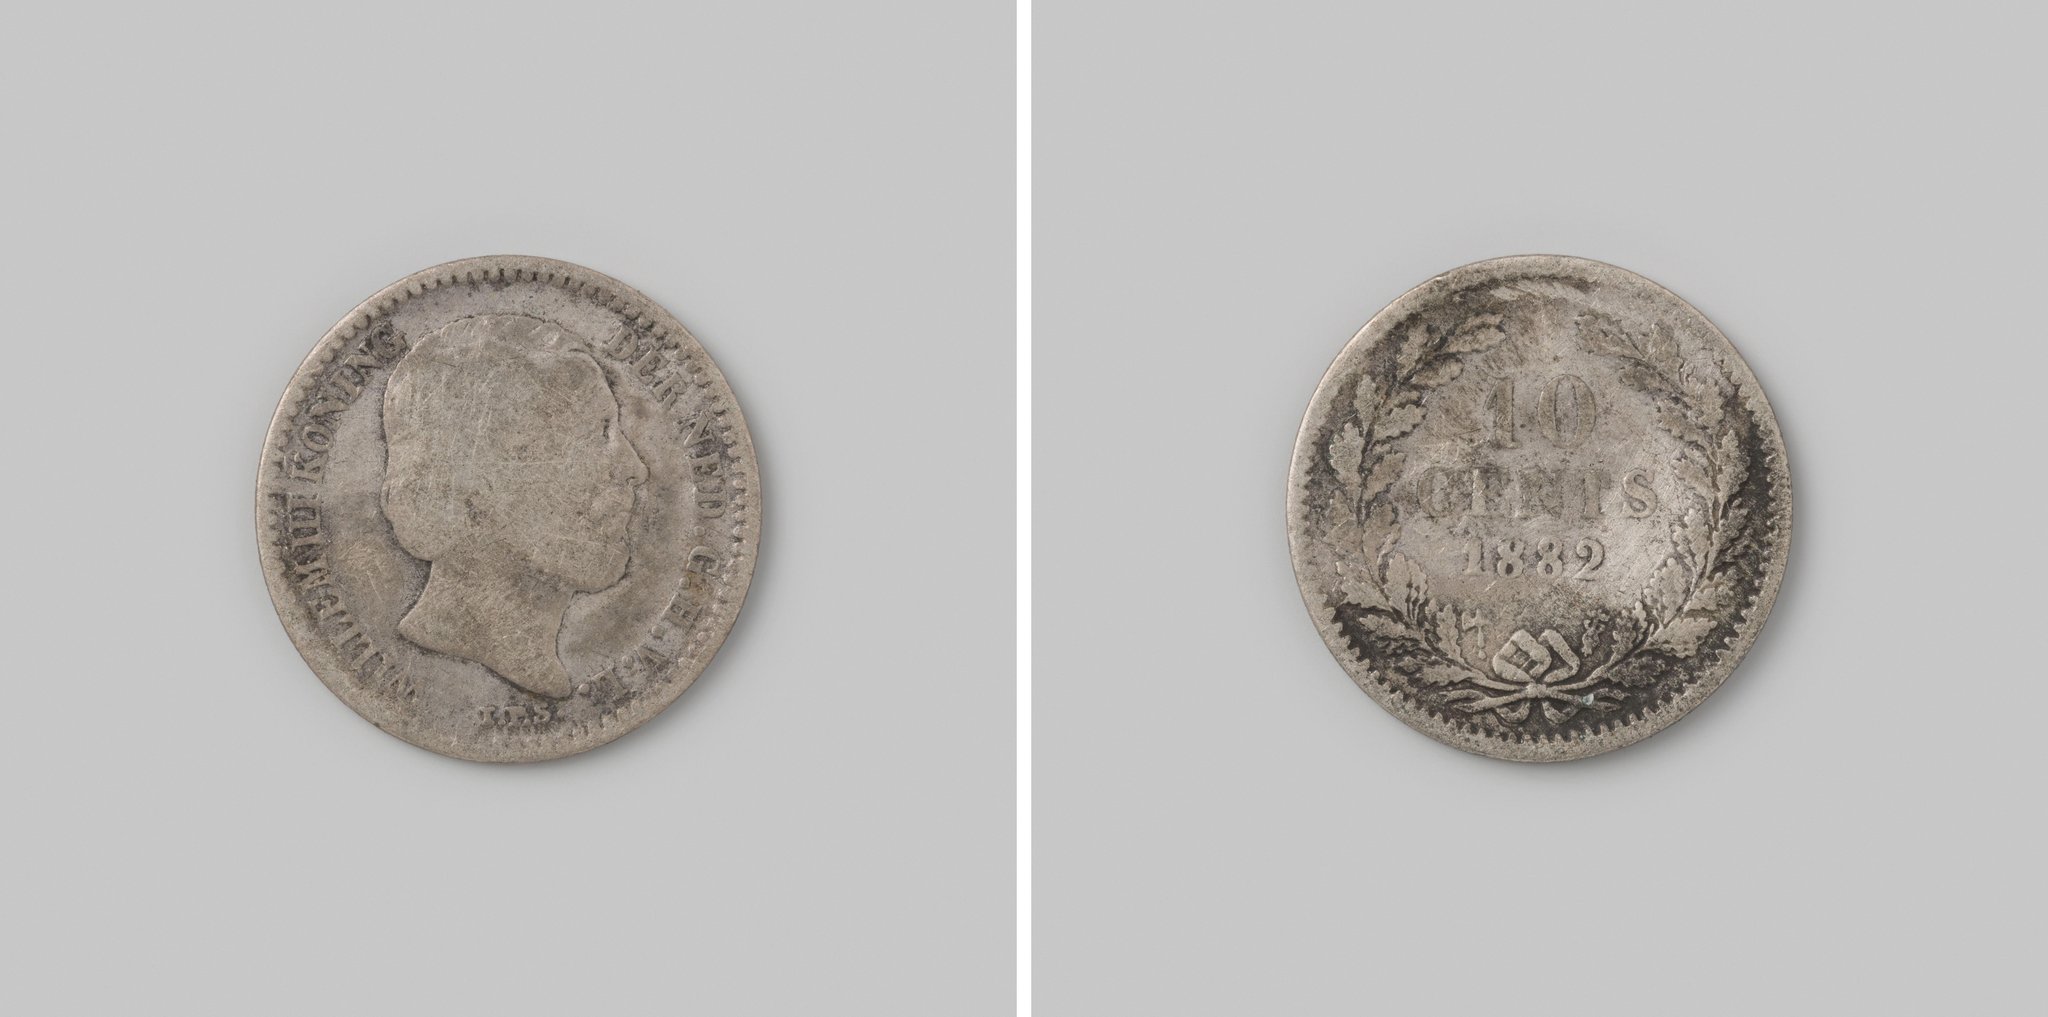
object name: coin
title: Nederlandse 10 cent, 1882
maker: willem iii (koning der nederlanden)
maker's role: koning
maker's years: 1817-1890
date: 1882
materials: silver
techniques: striking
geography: utrecht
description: Zilveren munt. Voorzijde: borstbeeld naar rechts. Keerzijde: binnen twee samengebonden eiketakken waarde-aanduiding 10 cents en jaartal. Kartelrand.